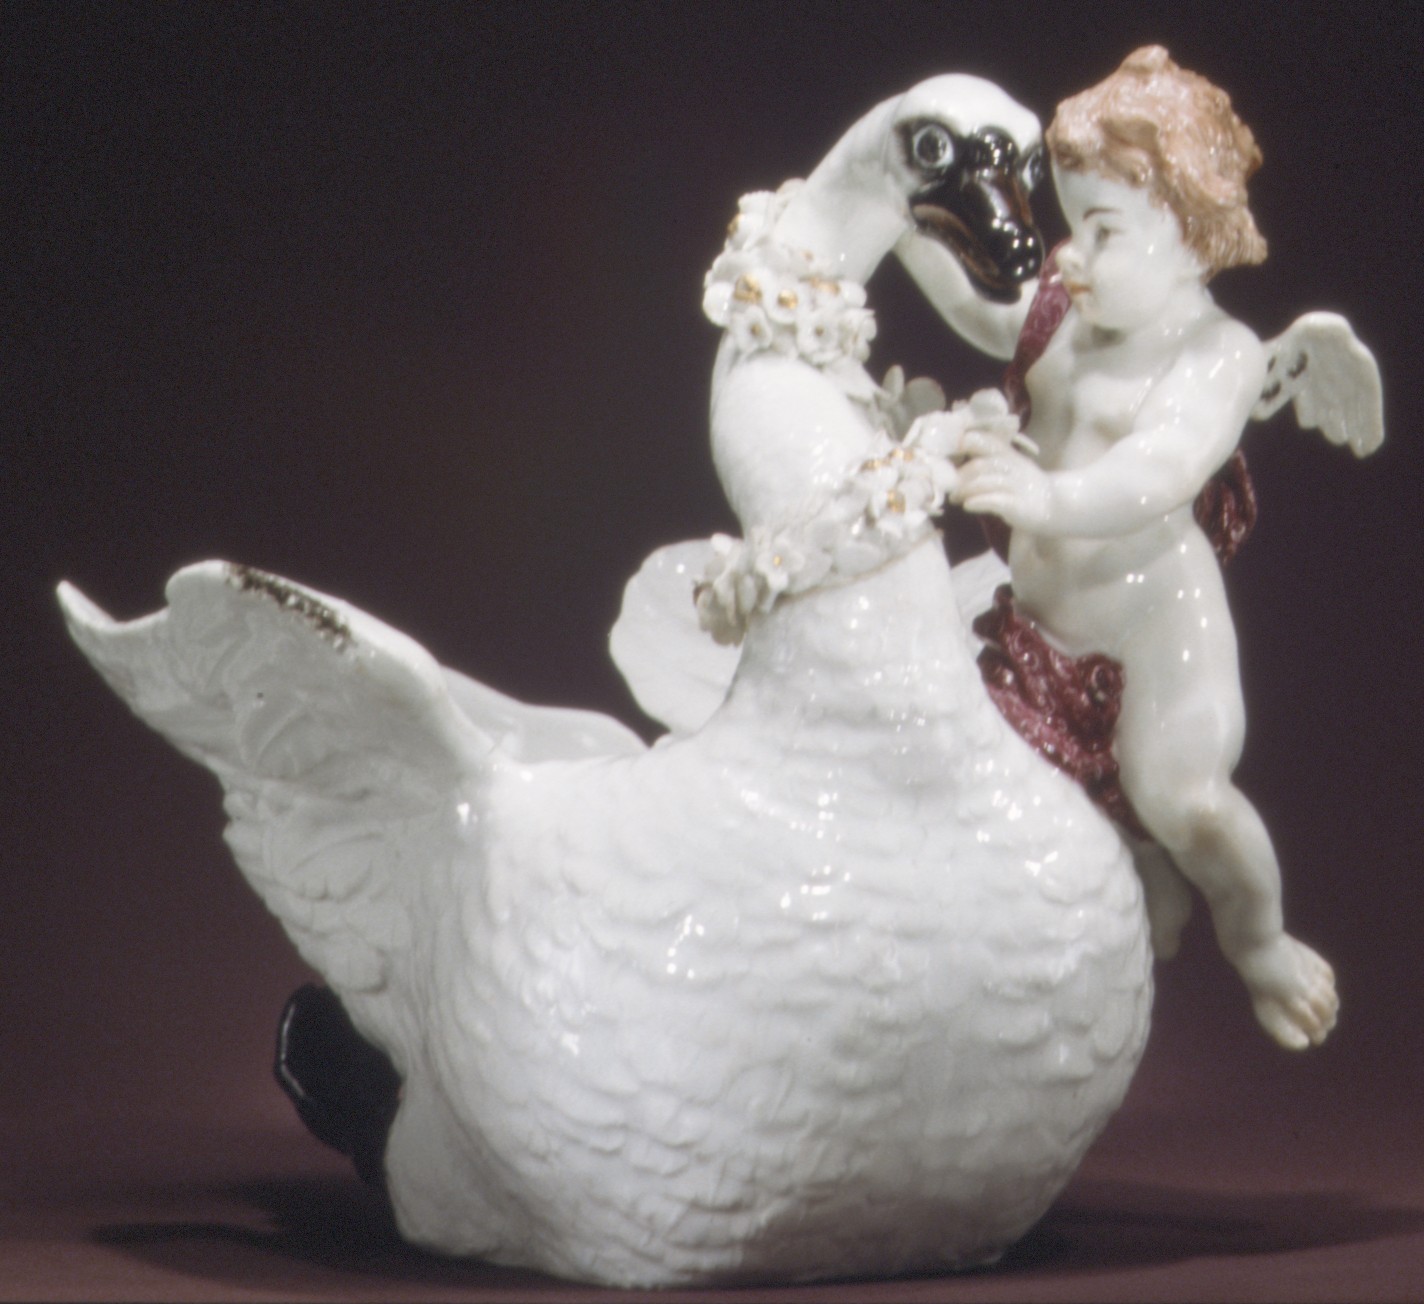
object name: sauceboat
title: Sauceboat (part of a service)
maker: meissen manufactory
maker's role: manufactory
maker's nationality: german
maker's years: 1710-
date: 1738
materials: hard paste porcelain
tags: putti,swans